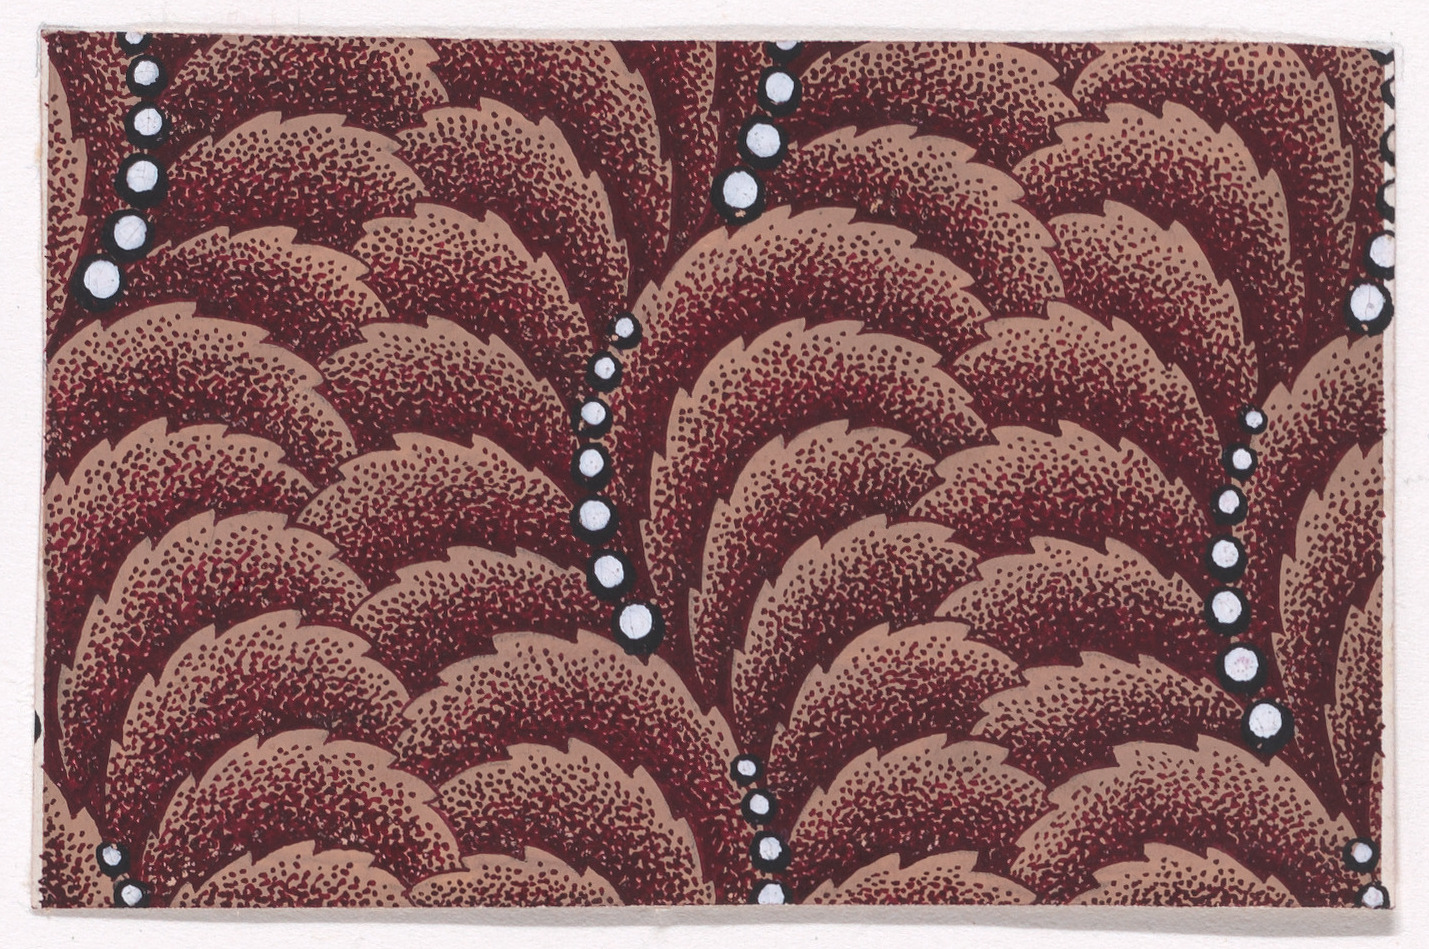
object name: drawing ornament architecture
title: Textile Design with Undulating Vertical Rows of Overlapping Scales and Curved Strips of Pearls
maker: anonymous, alsatian, 19th century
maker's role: artist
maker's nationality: alsatian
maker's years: 1800-1900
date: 1840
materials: gouache